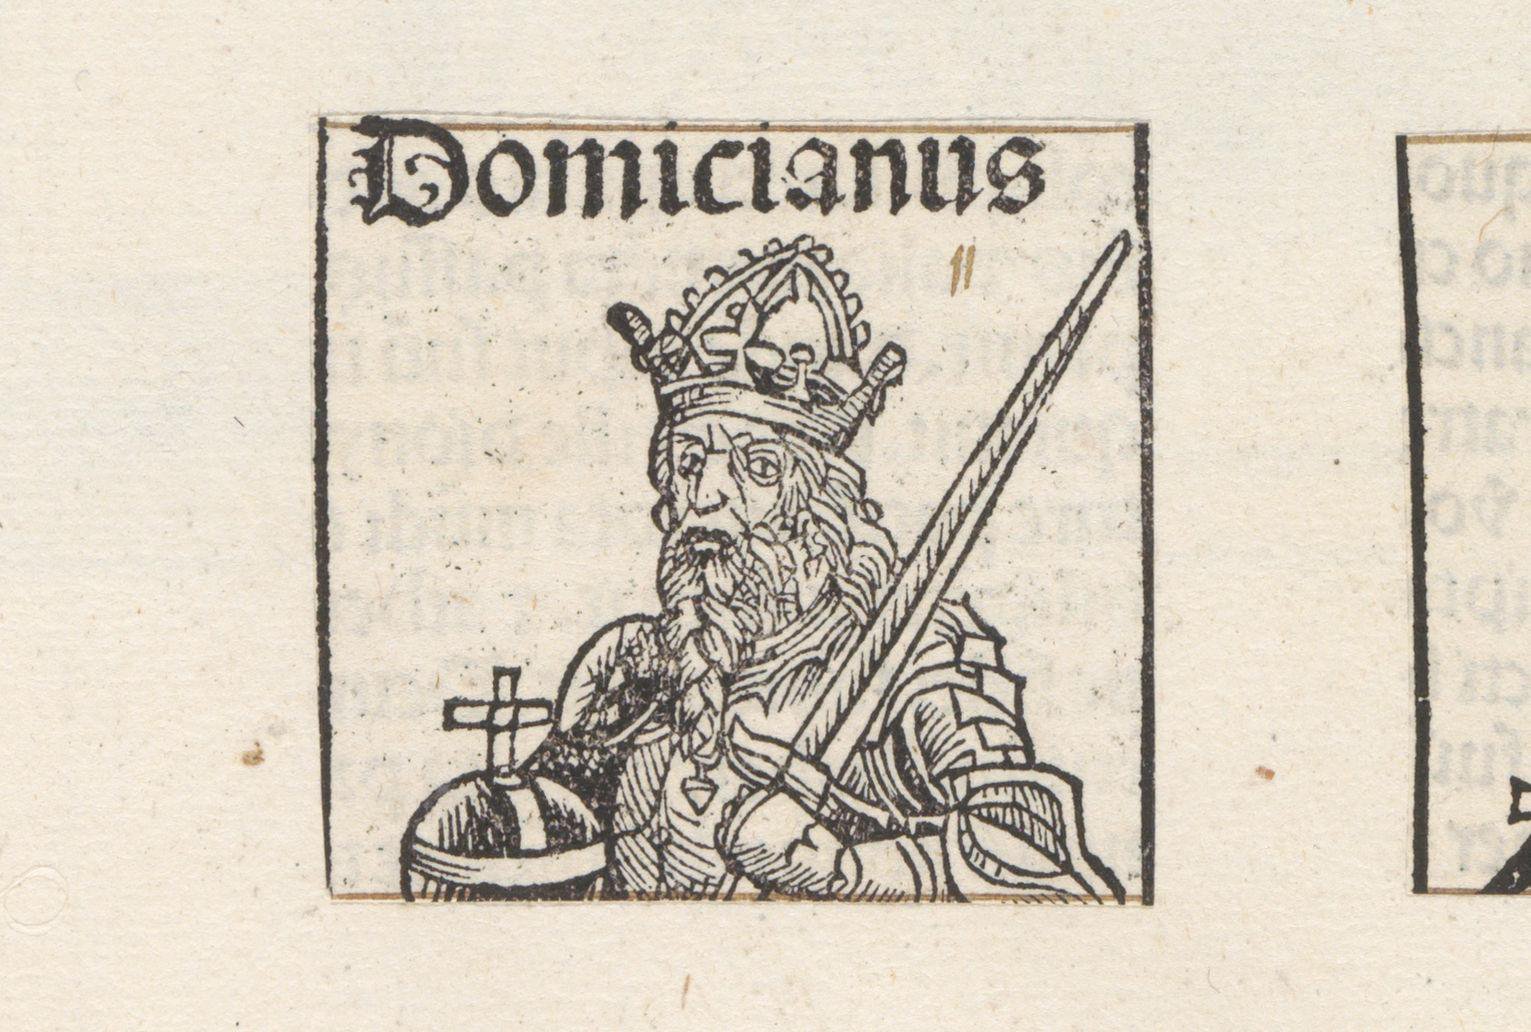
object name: album leaf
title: Liber Chronicarum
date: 1493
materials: paper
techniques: letterpress printing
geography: nuremberg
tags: emperor, king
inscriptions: inscription: ‘11[?]’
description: Een halve koning, naar links gekeerd. In zijn handen heeft hij een zwaard en een rijksappel. De voorstelling is onderdeel van de opeenvolging keizers in de Liber Chronicarum. De tekst identificeert de man als Domitianus. De prent maakt deel uit van een album.